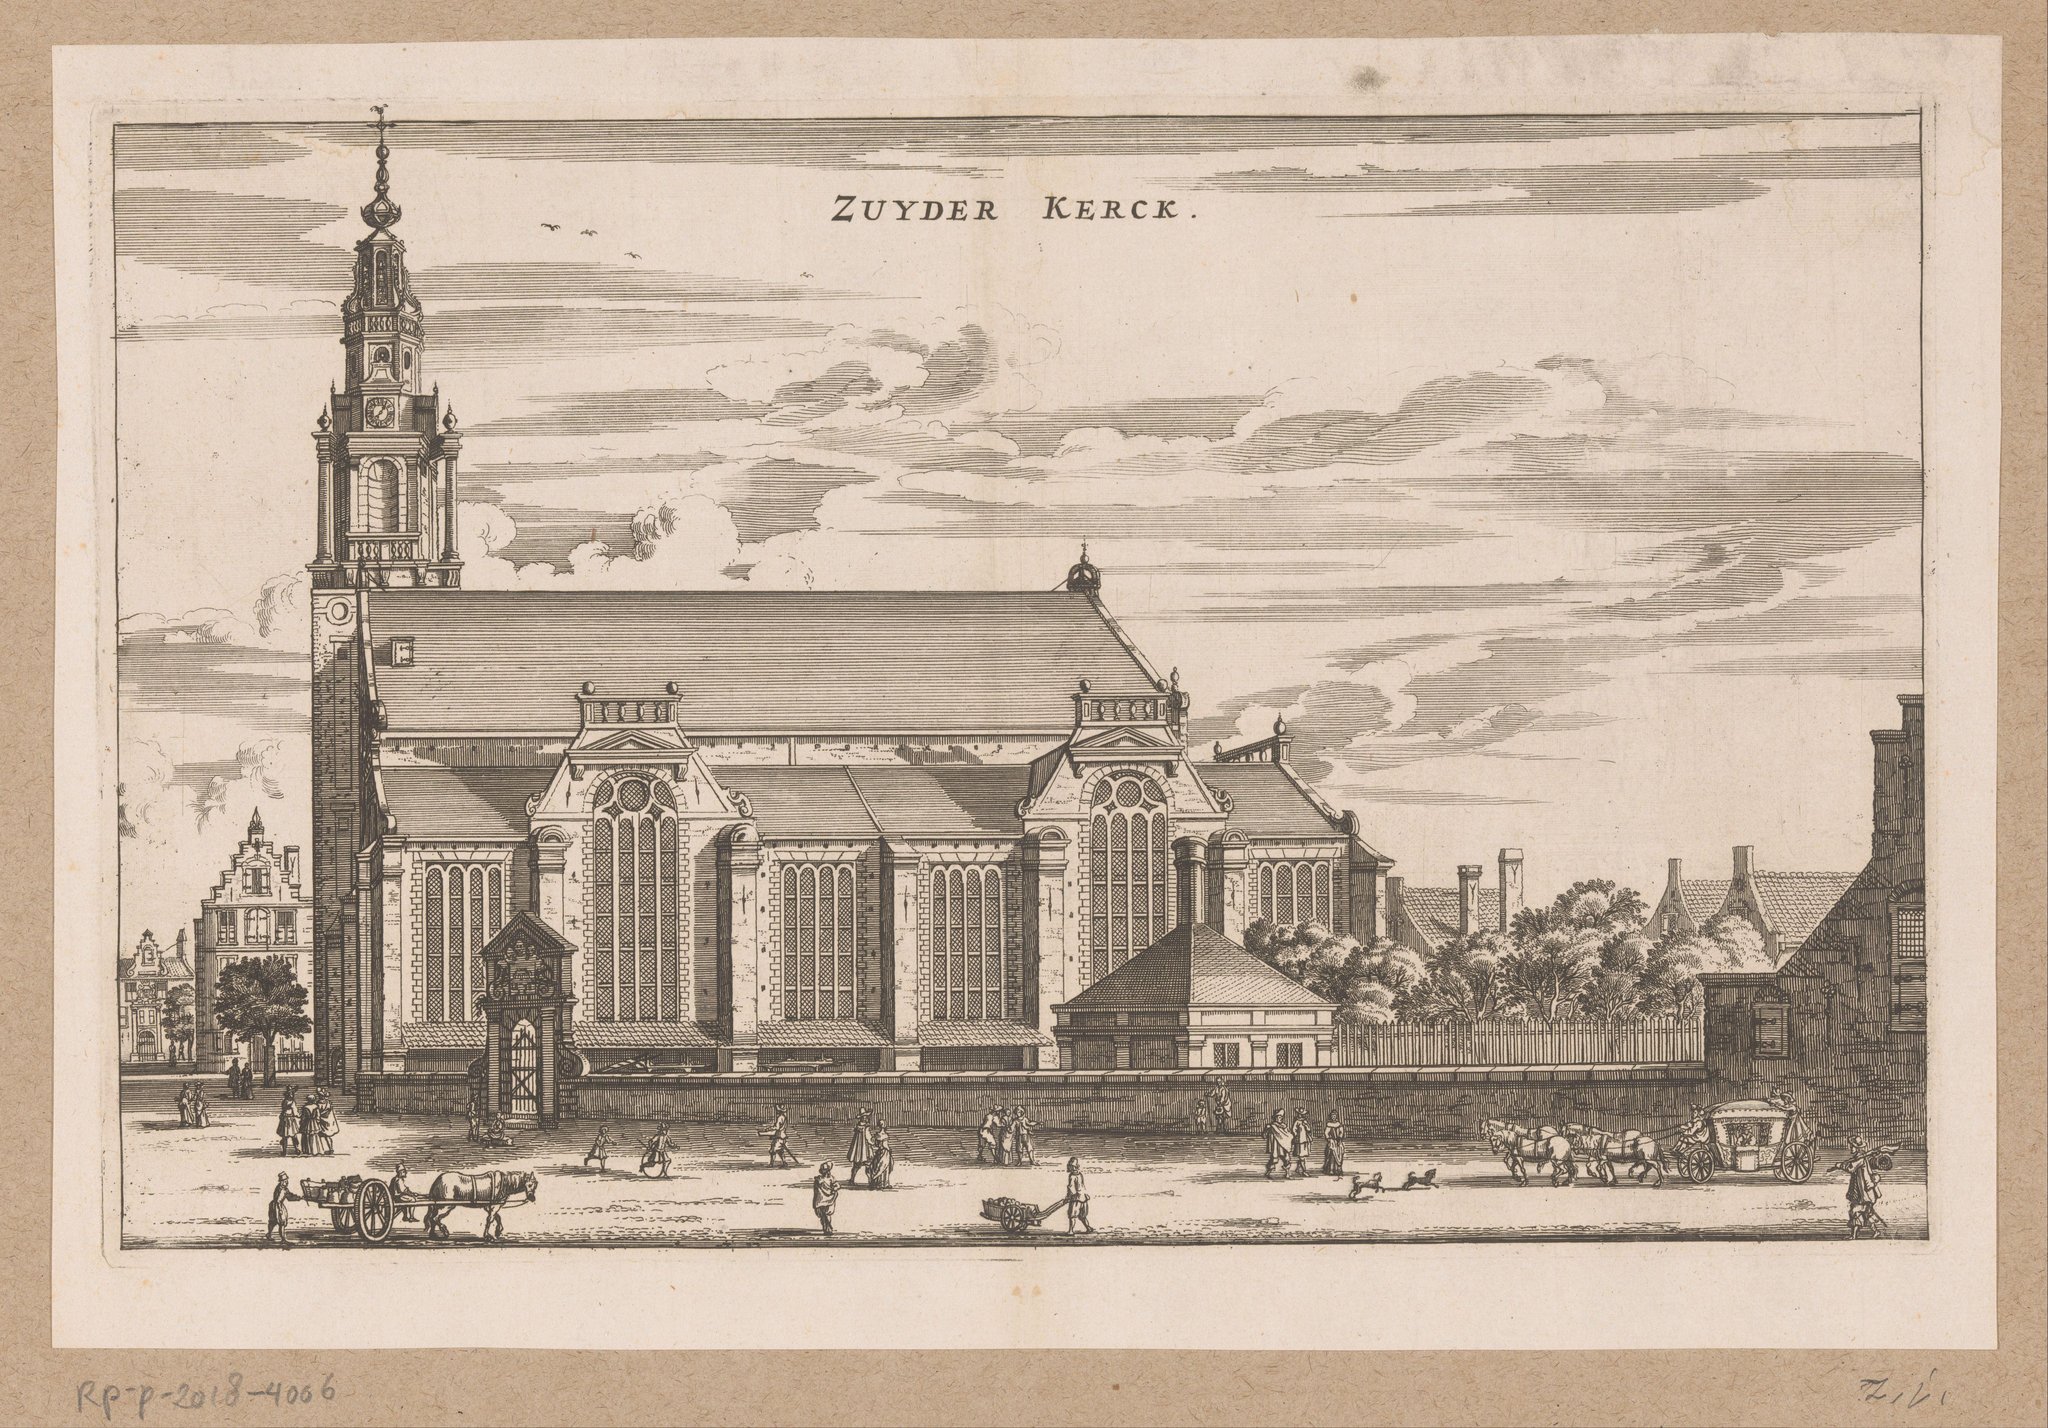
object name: print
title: Gezicht op de Zuiderkerk te Amsterdam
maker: jacob van meurs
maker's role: draughtsman, print maker, publisher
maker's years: 1619-1680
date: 1663-1664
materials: paper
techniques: etching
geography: amsterdam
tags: church (exterior), city-view, and landscape with man-made constructions (+ city(-scape) with figures, staffage)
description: Prent uit: Dapper, Olfert. Historische beschryving der stadt Amsterdam: waer in de voornaemste geschiedenissen (na een kort verhael van gansch Hollant en d'omleggende dorpen (…). Amsterdam: Jacob van Meurs, 1663. Of uit: Zesen, Philipp von. Beschreibung der Stadt Amsterdam: darinnen von derselben ersten Ursprunge bis auf gegenwärtigen Zustand (…). Amsterdam: Joachim Nosche, 1664. Bij de tweede staat is een Franse titel toegevoegd.